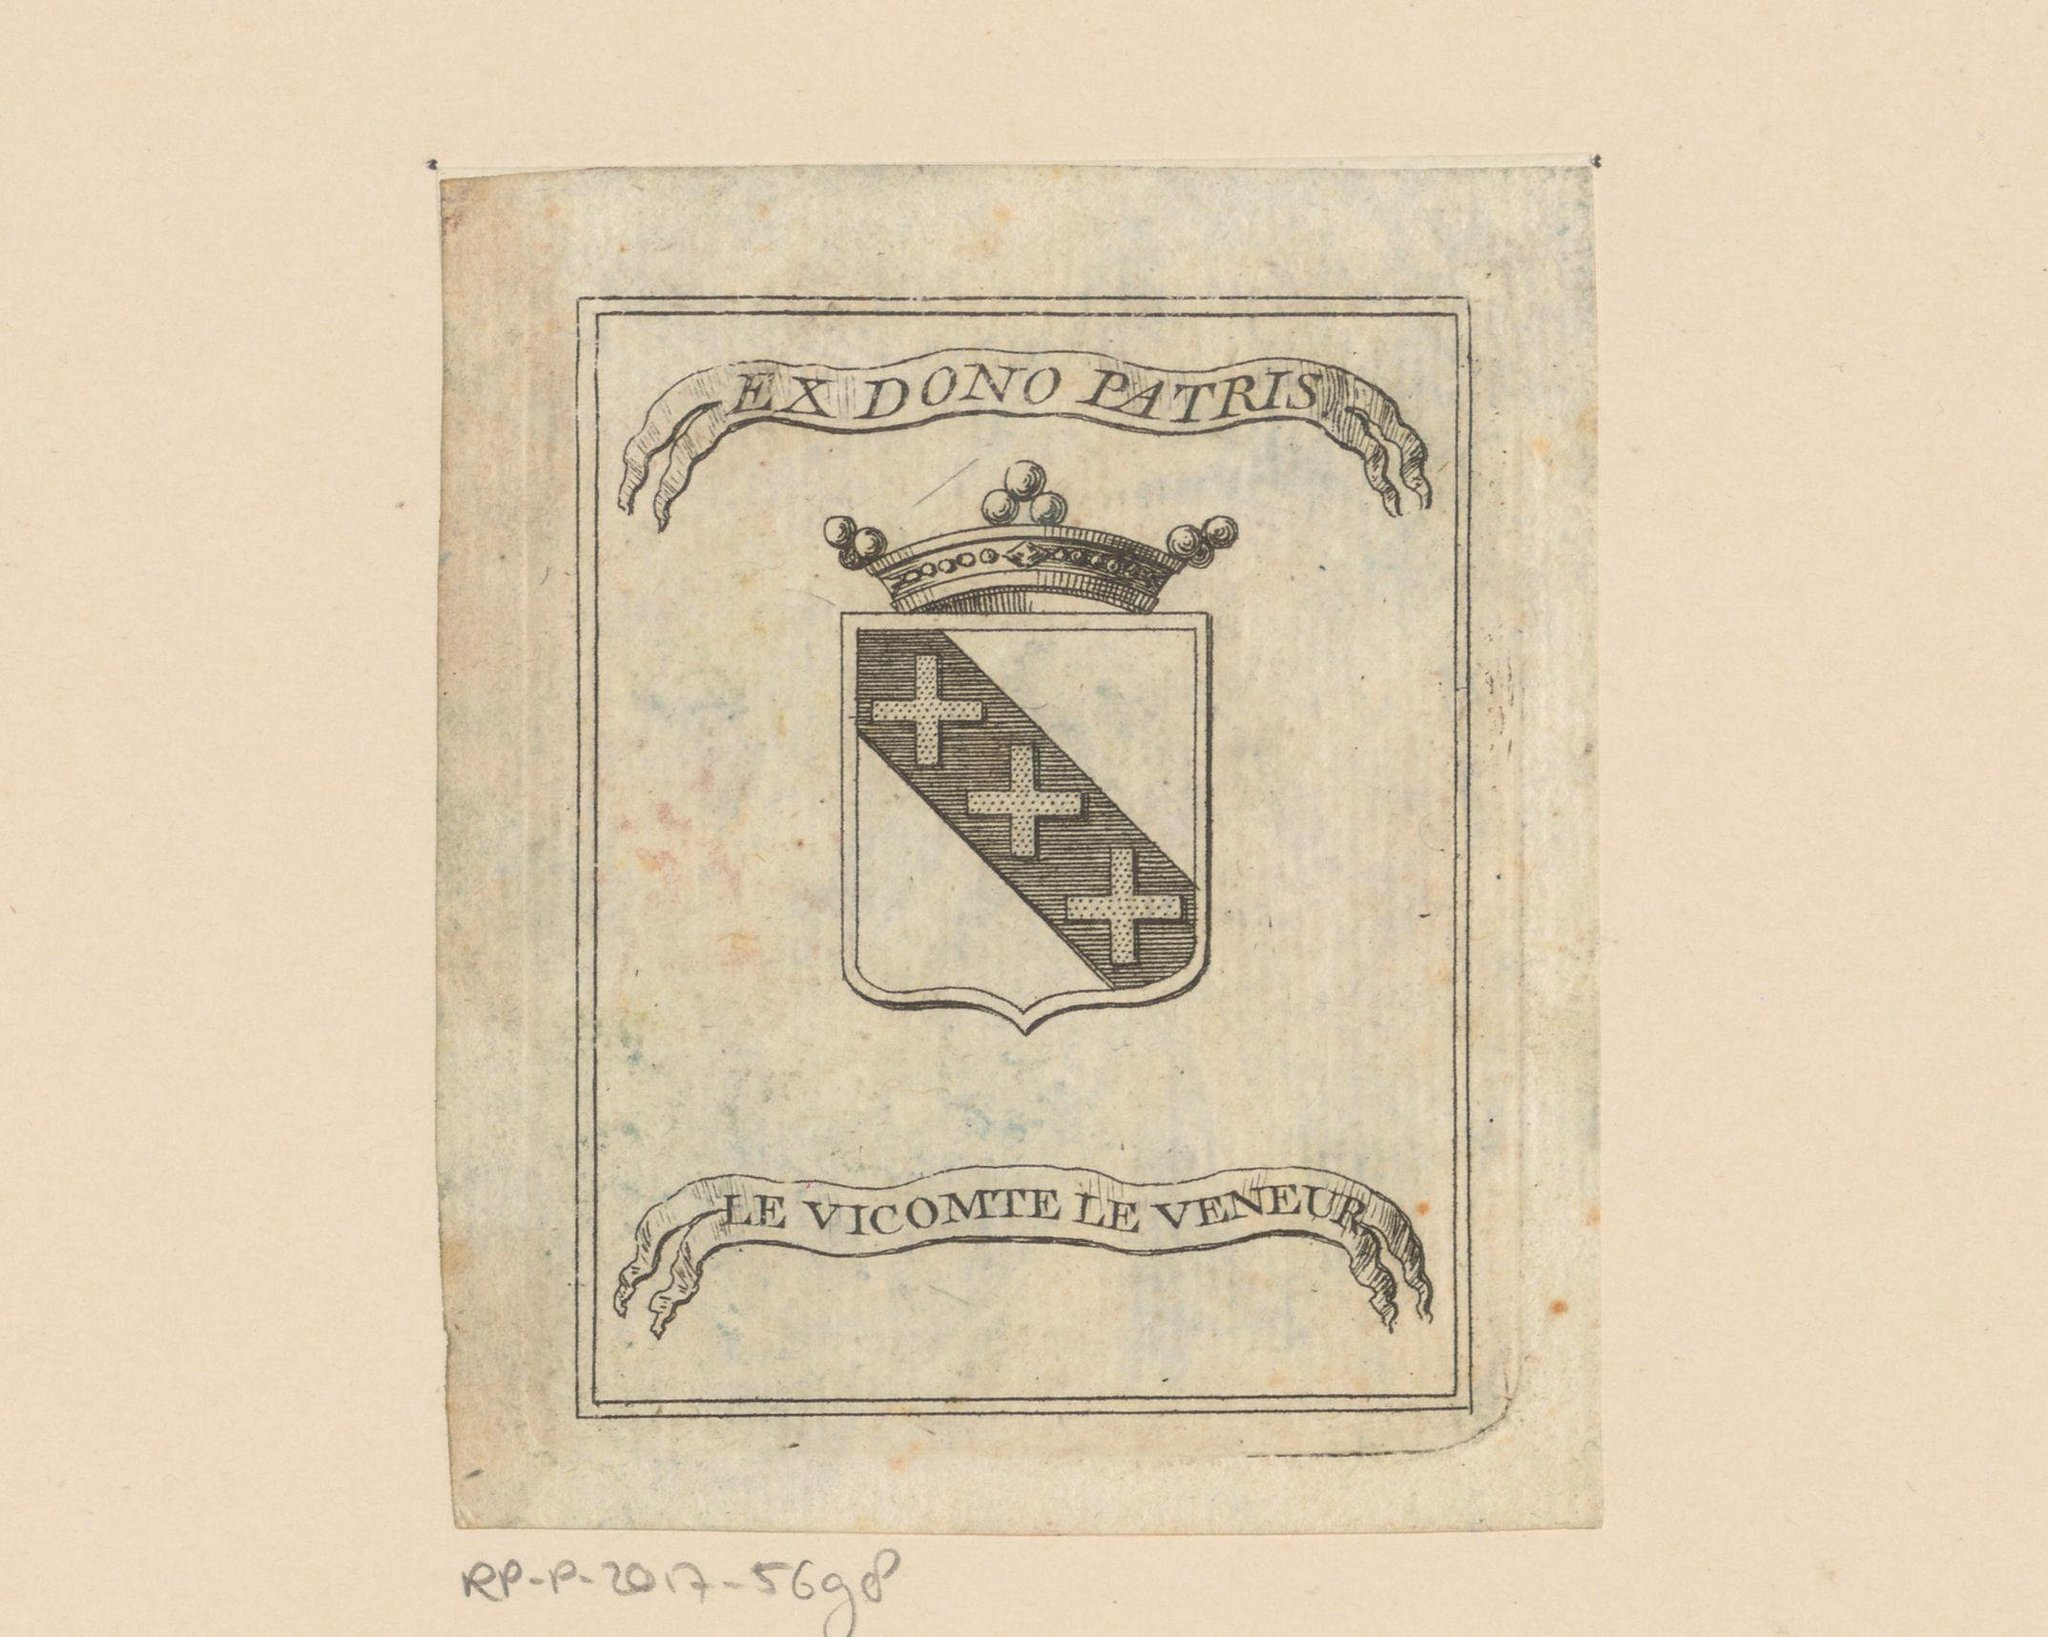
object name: bookplate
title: Ex libris van burggraaf Le Veneur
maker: Anonymous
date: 1750-1849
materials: paper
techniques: etching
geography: france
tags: paris, politician, armorial bearing, heraldry